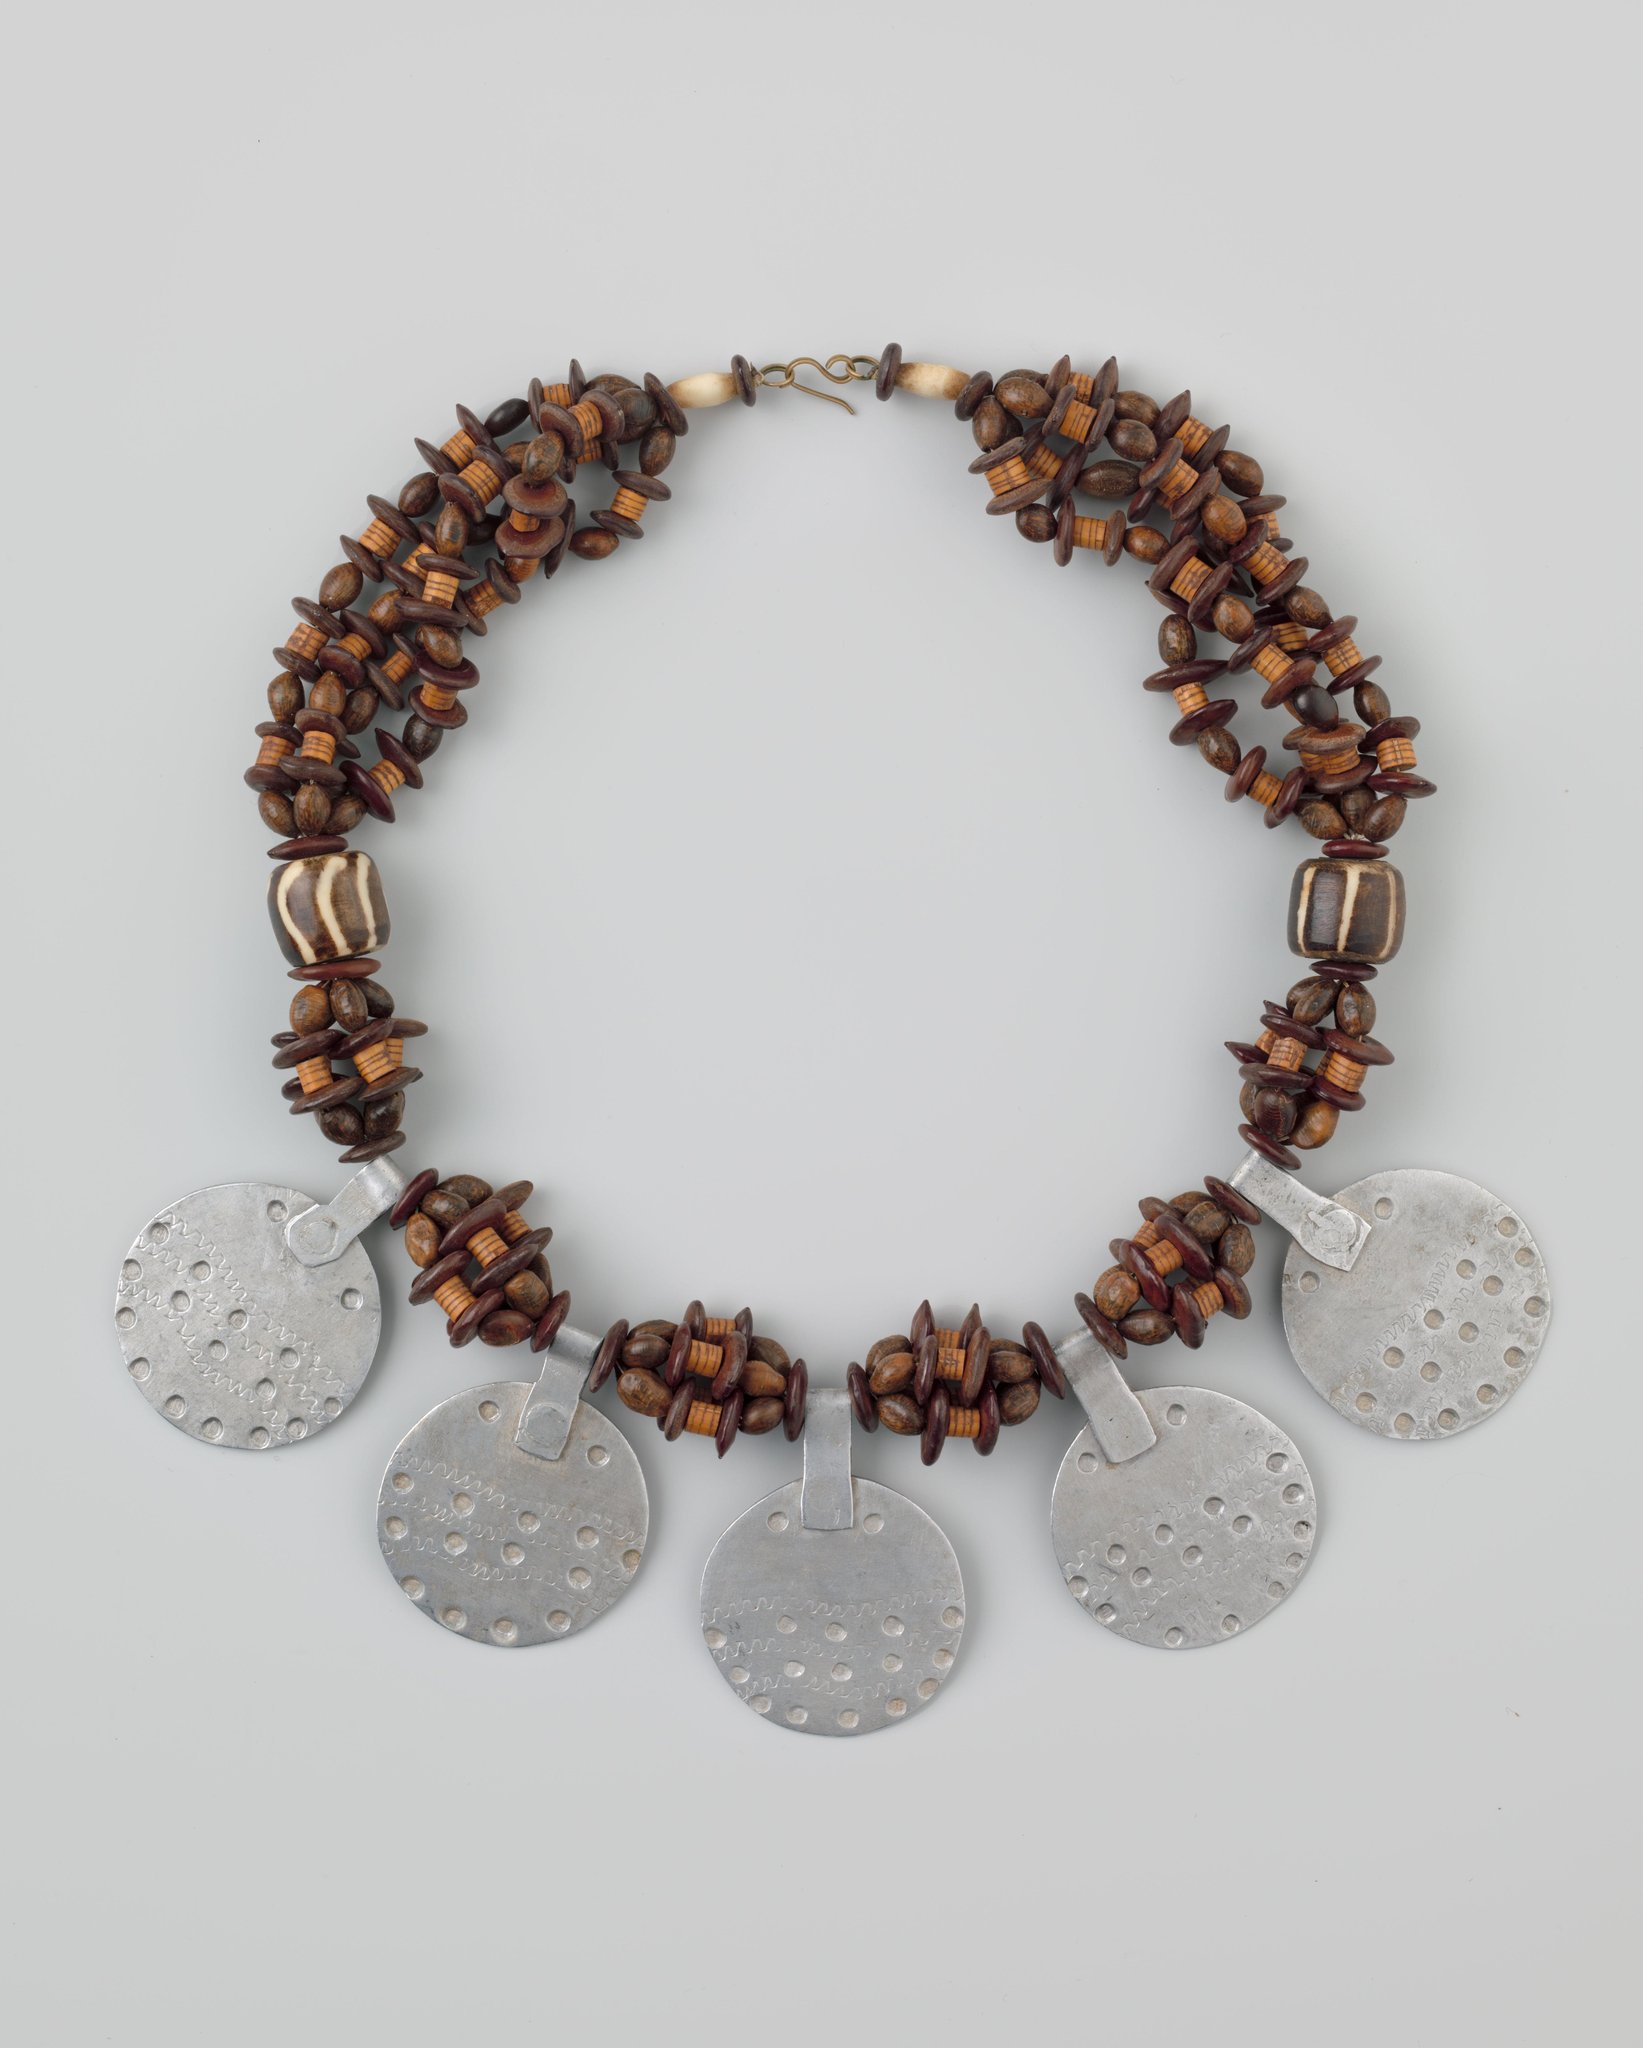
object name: necklace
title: Halssieraad van aluminium en zaden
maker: Anonymous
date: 1990-1998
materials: aluminum, brass, plant material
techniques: engraving, perforating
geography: kenya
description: Halssieraad van vijf aluminium cirkels hangend aan een streng van zaden en twee kralen. Sluiting van messingdraad met een haak en een oog.